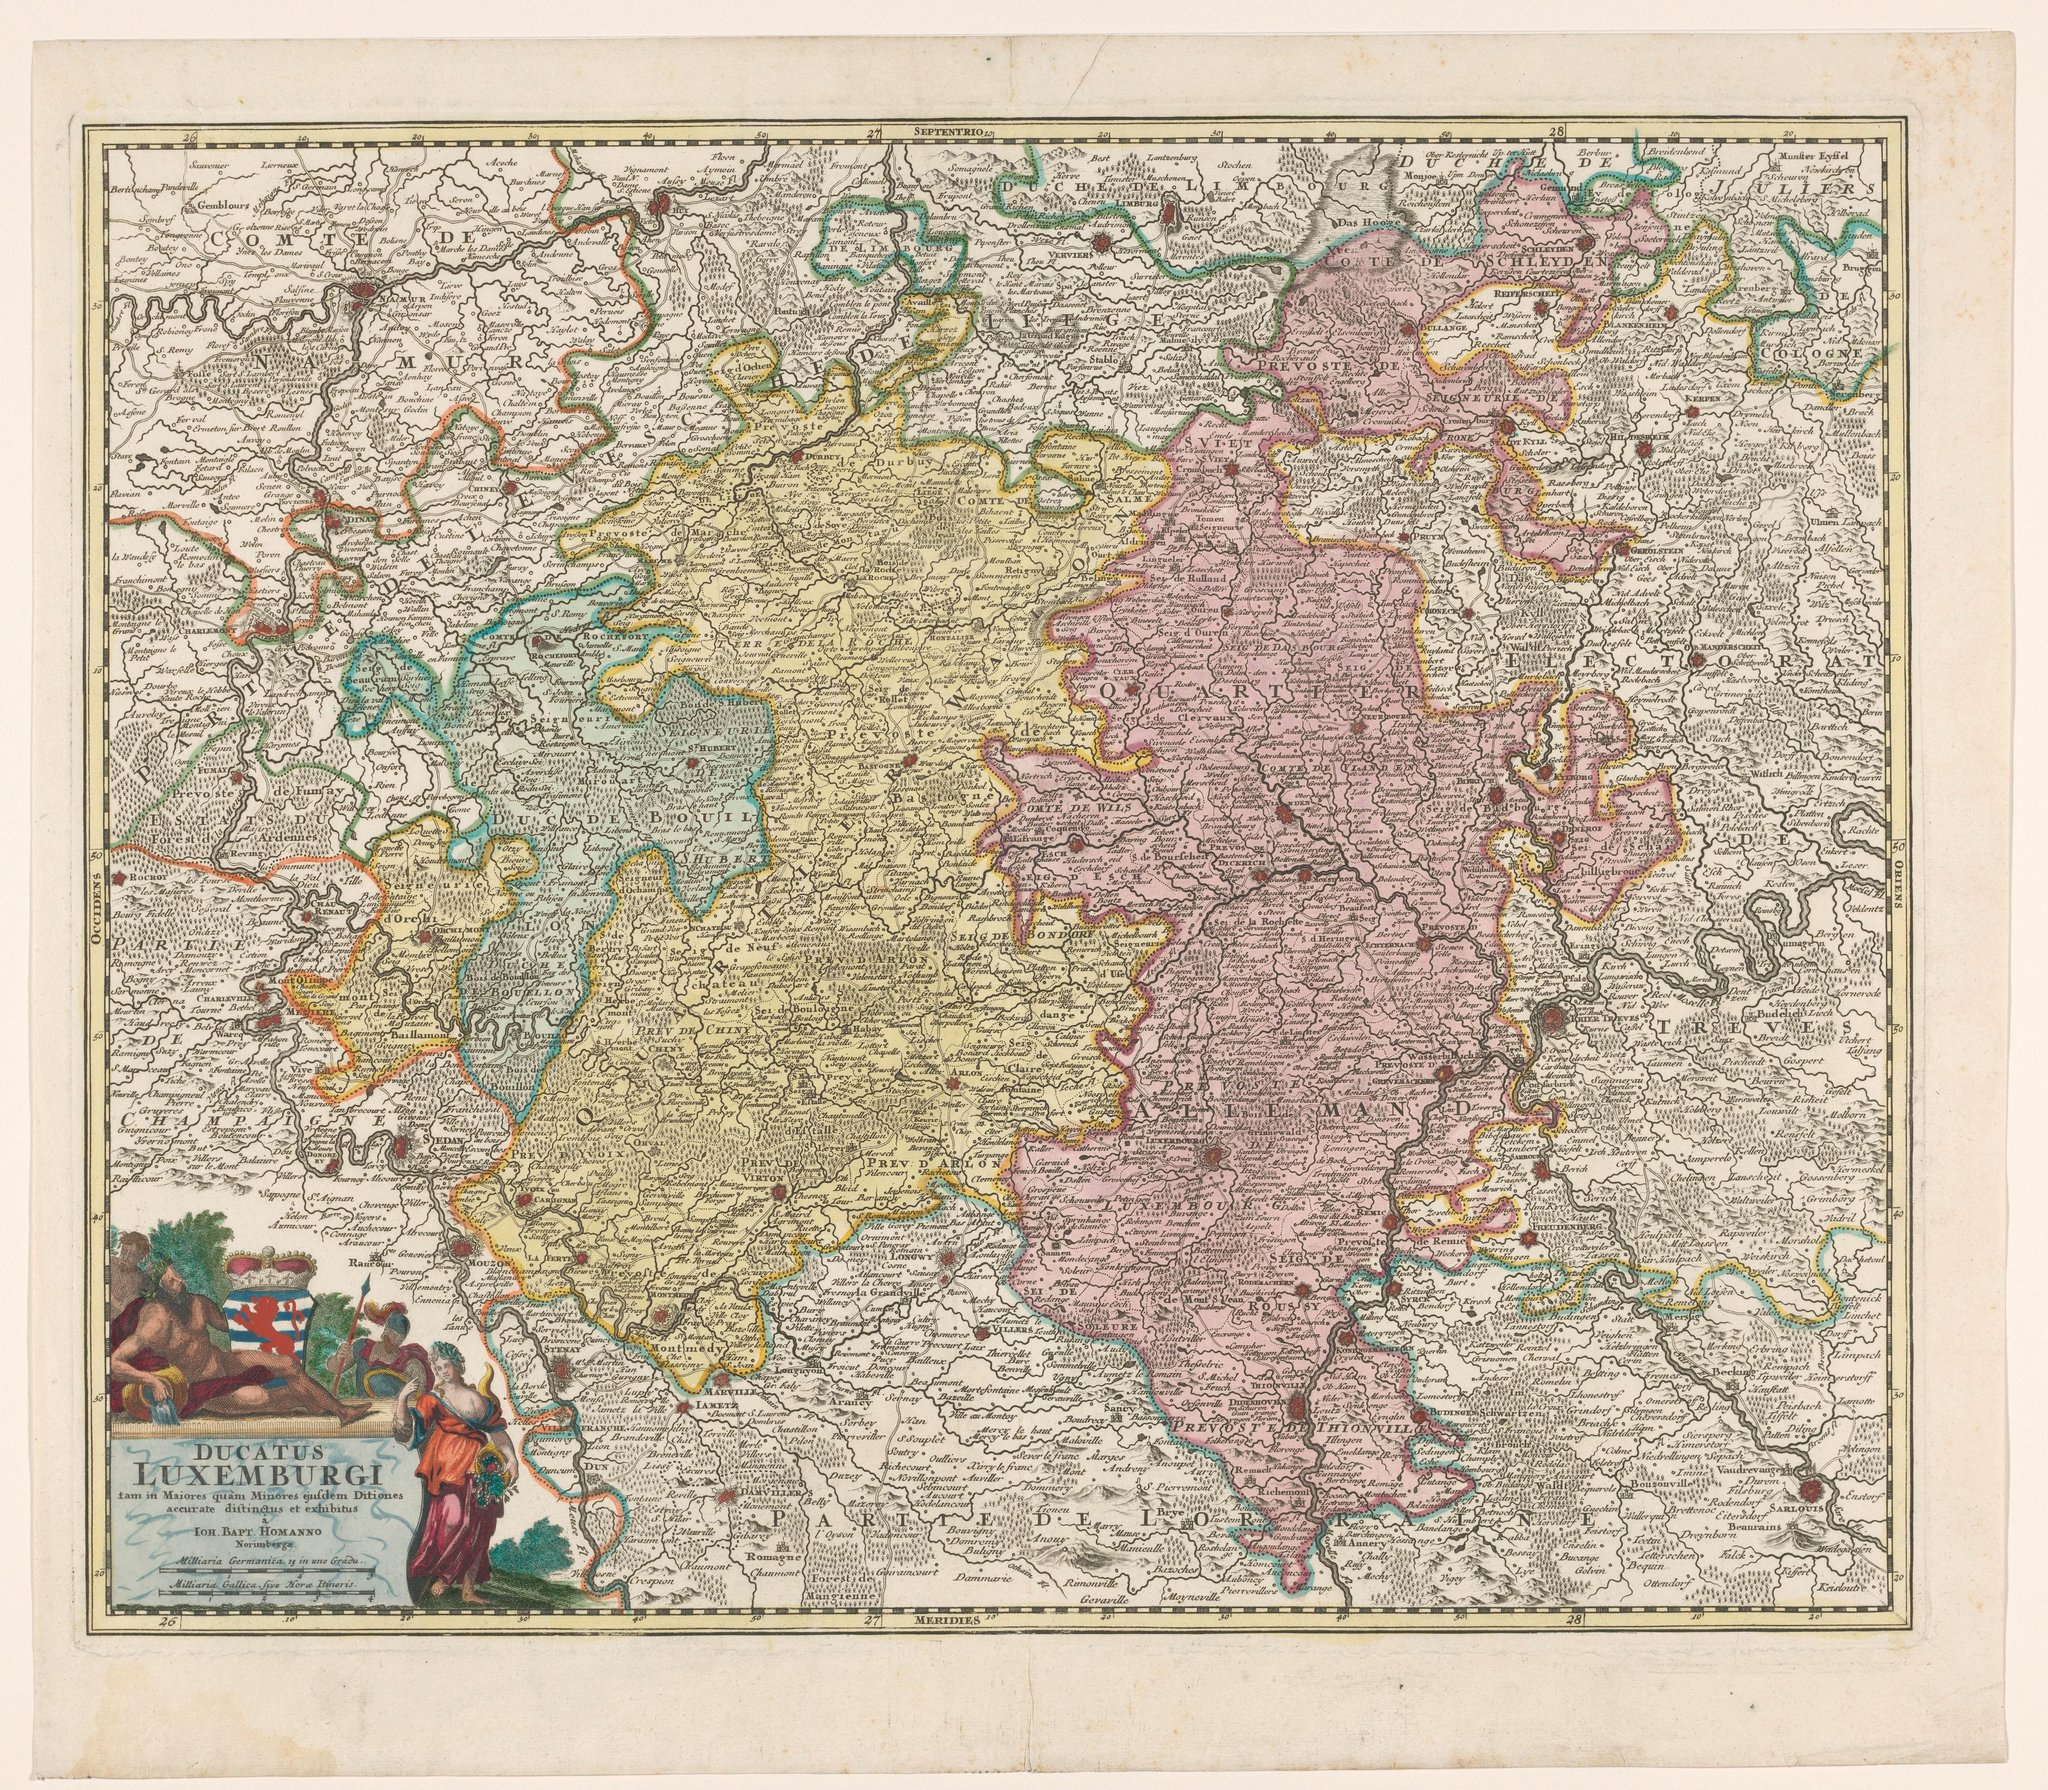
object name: print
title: Ducatus Luxemburgi tam in maiores quam minores (...)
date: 1674-1724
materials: paper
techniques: engraving, etching, hand coloring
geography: nuremberg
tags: maps of separate countries or regions, coat of arms (as symbol of the state, etc.) (+ province; provincial)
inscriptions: collector's mark: Lugt 2228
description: Kaart van het hertogdom Luxemburg. Linksonder de titelcartouche met boven het wapen van het hertogdom Luxemburg en onder twee schaalstokken: Milliaria Germanica 15 in uno Gradu / Milliaria Gallica, sive Horae Itineris. De kaart is voorzien van een gradenverdeling langs de randen.